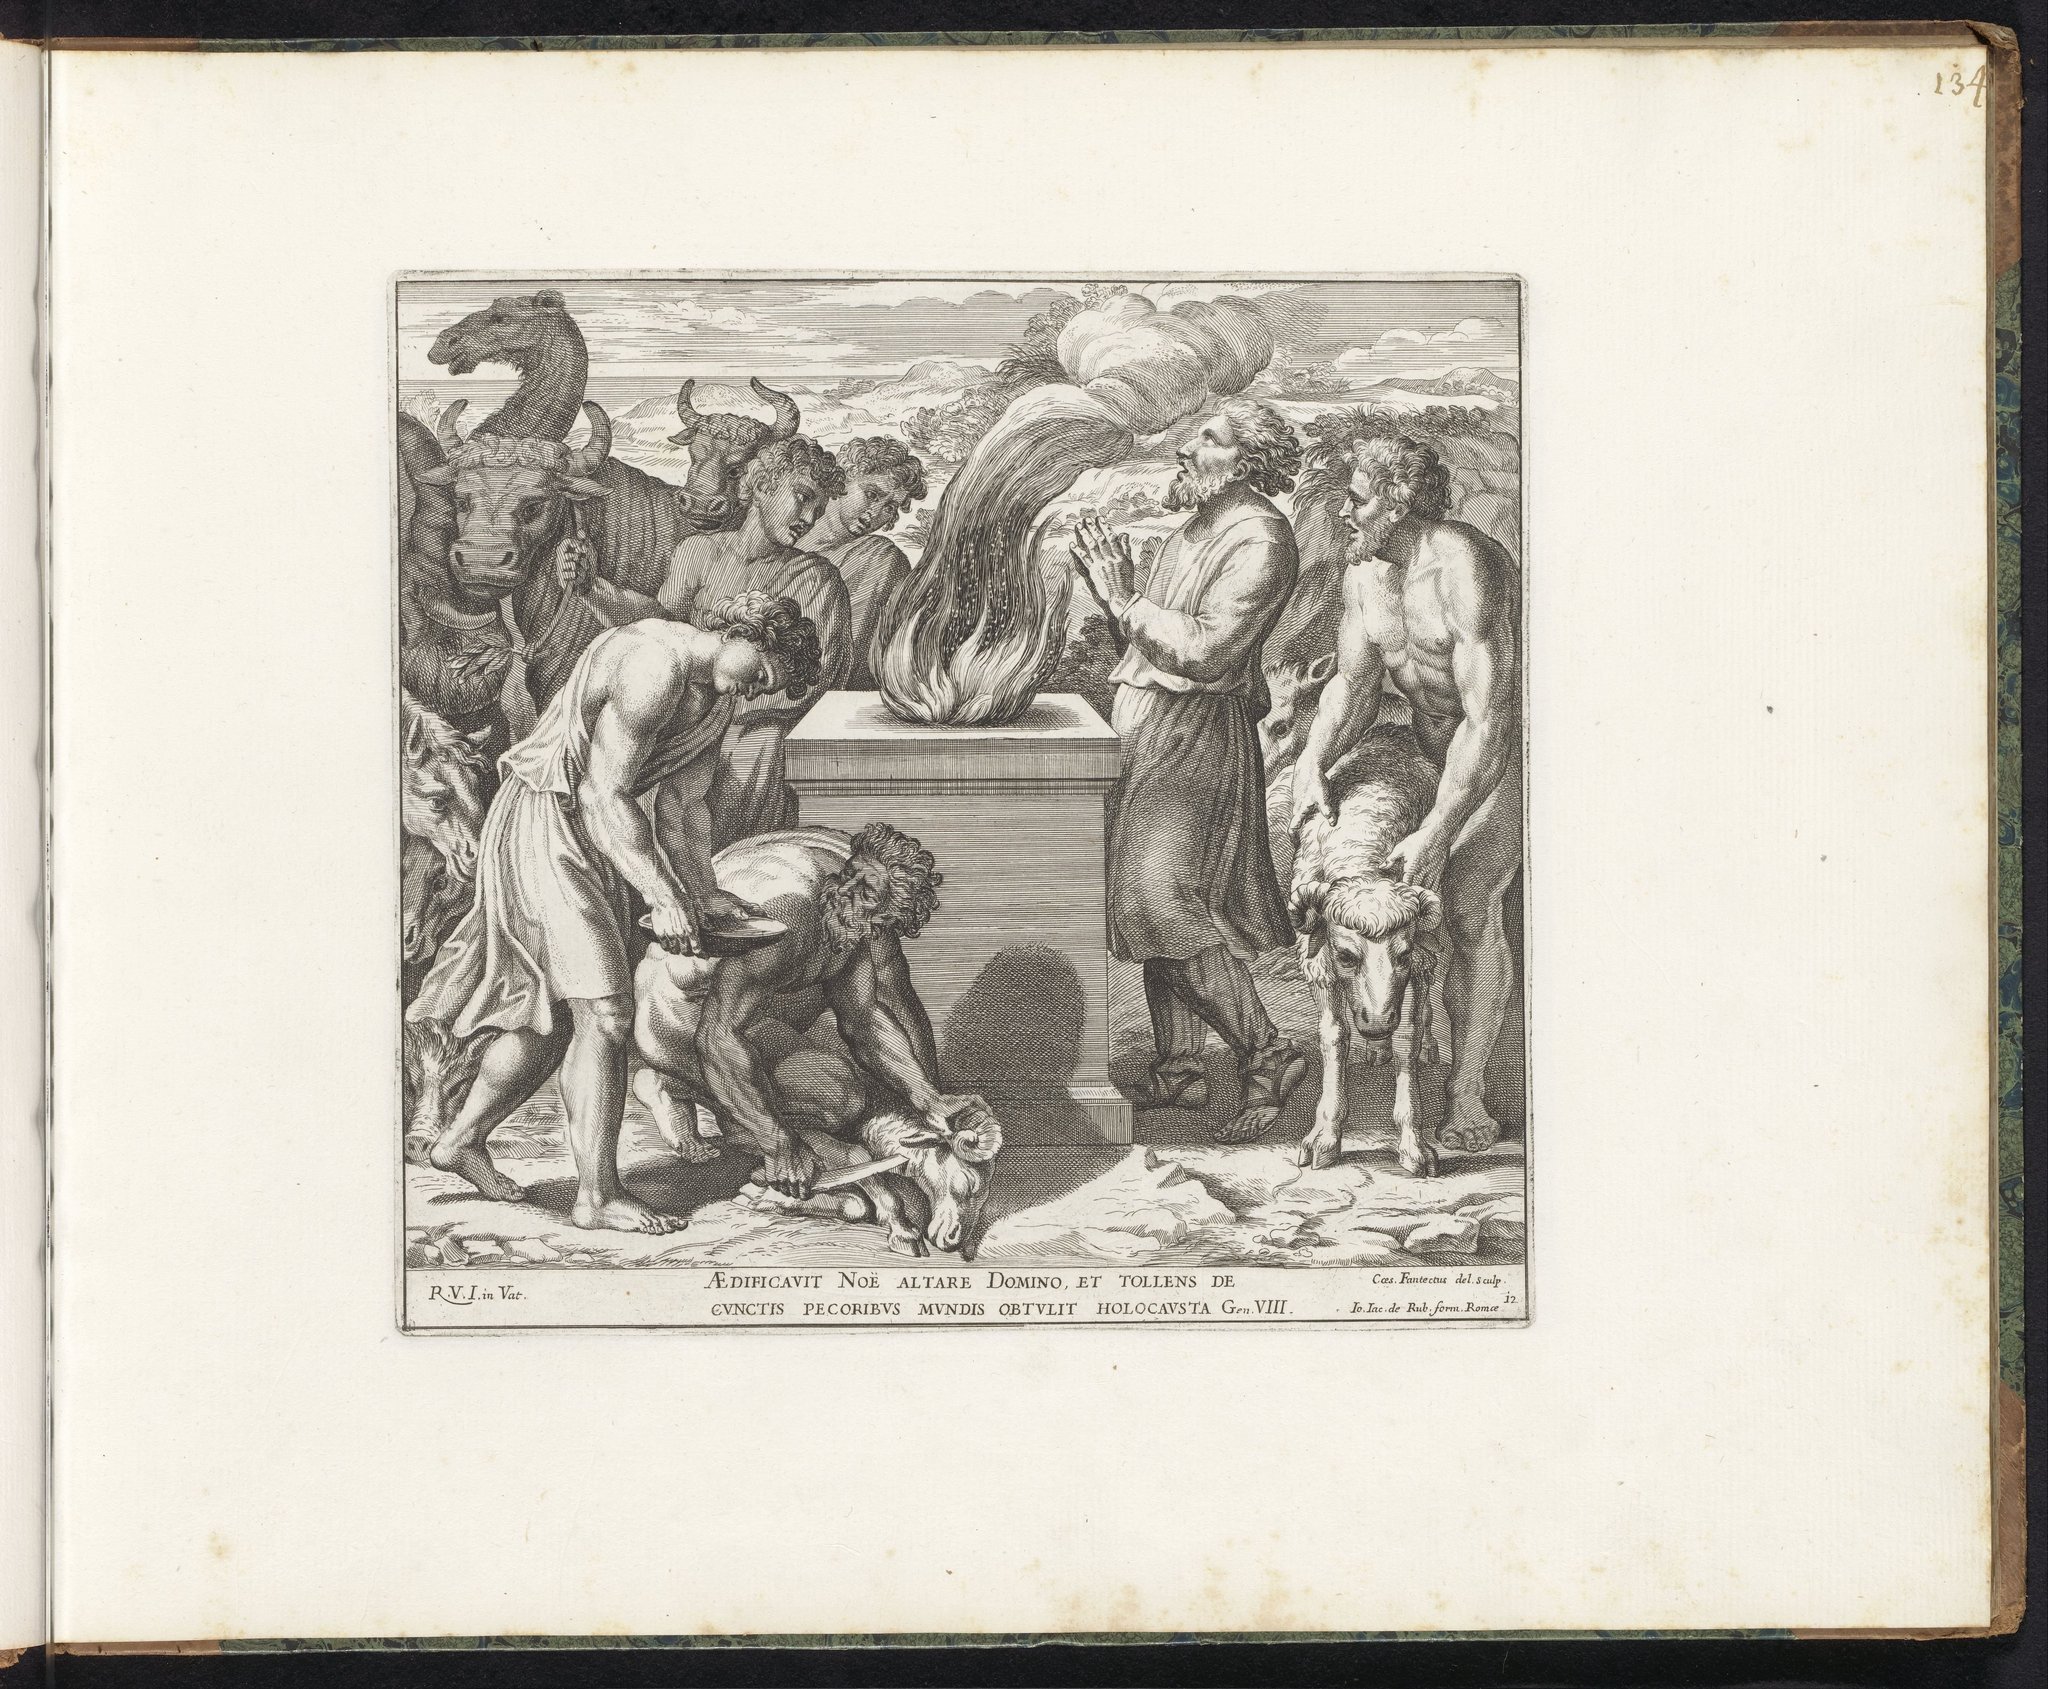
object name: print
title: Rafaël Bijbel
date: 1675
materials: paper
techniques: etching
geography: italy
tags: noah's sacrifice; various animals are offered, possibly a lamb, a dove and a ram (often combined with the rainbow of the covenant)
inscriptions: number: ‘134’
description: Prent maakt deel uit van een reeks van 55 prenten, bestaande uit drie ongenummerde prenten en een set van 52 genummerde prenten naar de schilderingen in de Loggia van Rafaël.